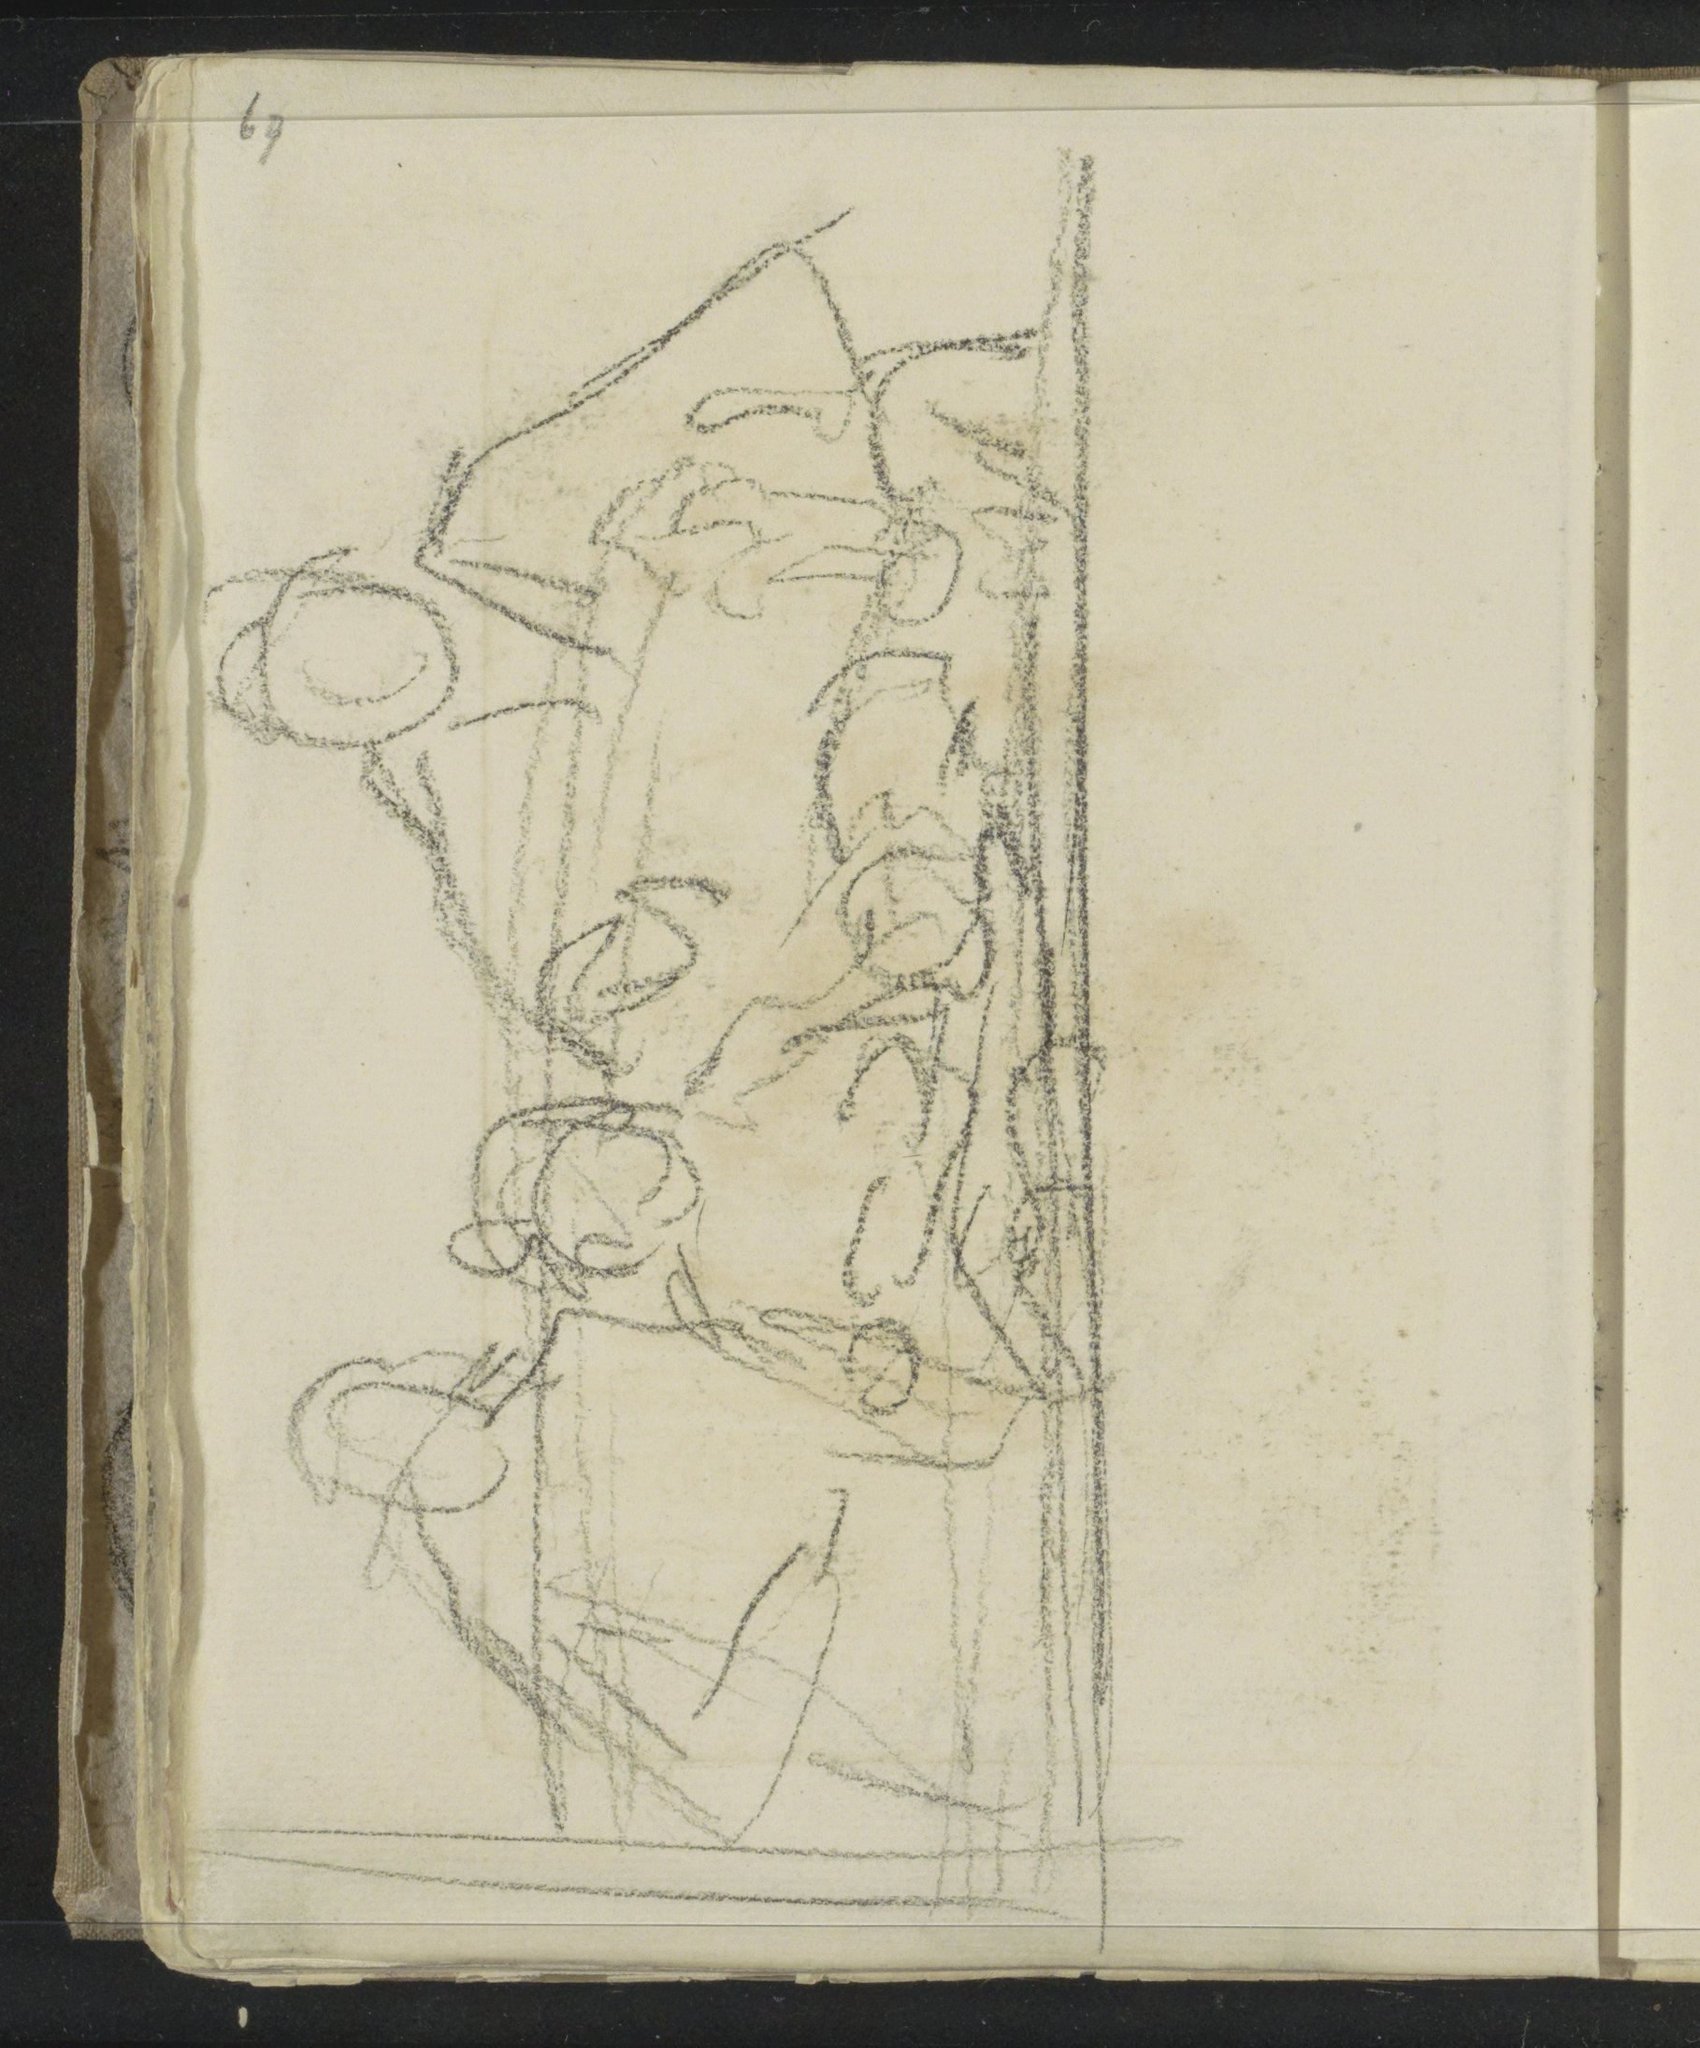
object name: sketchbook leaf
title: Compositiestudie met figuren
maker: floris arntzenius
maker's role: draughtsman, print maker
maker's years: 1864-1925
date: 1883-1914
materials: chalk, paper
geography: the hague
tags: adult woman, adult man, child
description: Pagina 67 uit een schetsboek met 82 pagina's.